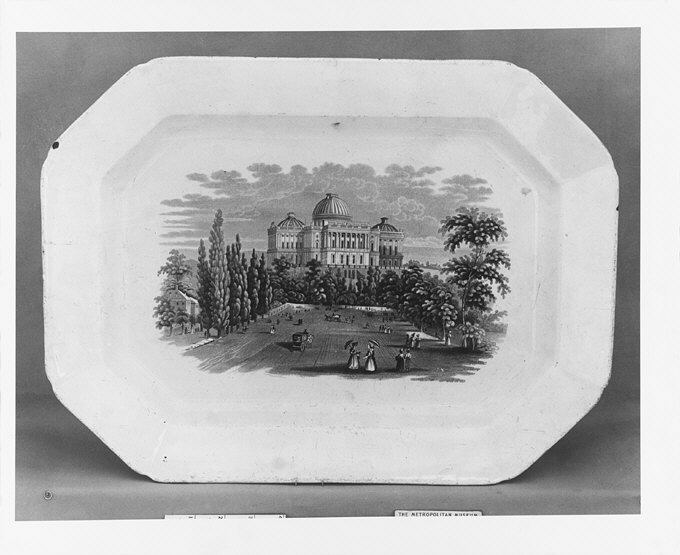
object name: platter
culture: british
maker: william ridgway & co.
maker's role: maker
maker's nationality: british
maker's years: 1834-1854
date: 1840-1854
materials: earthenware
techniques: transfer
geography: england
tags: buildings,landscapes